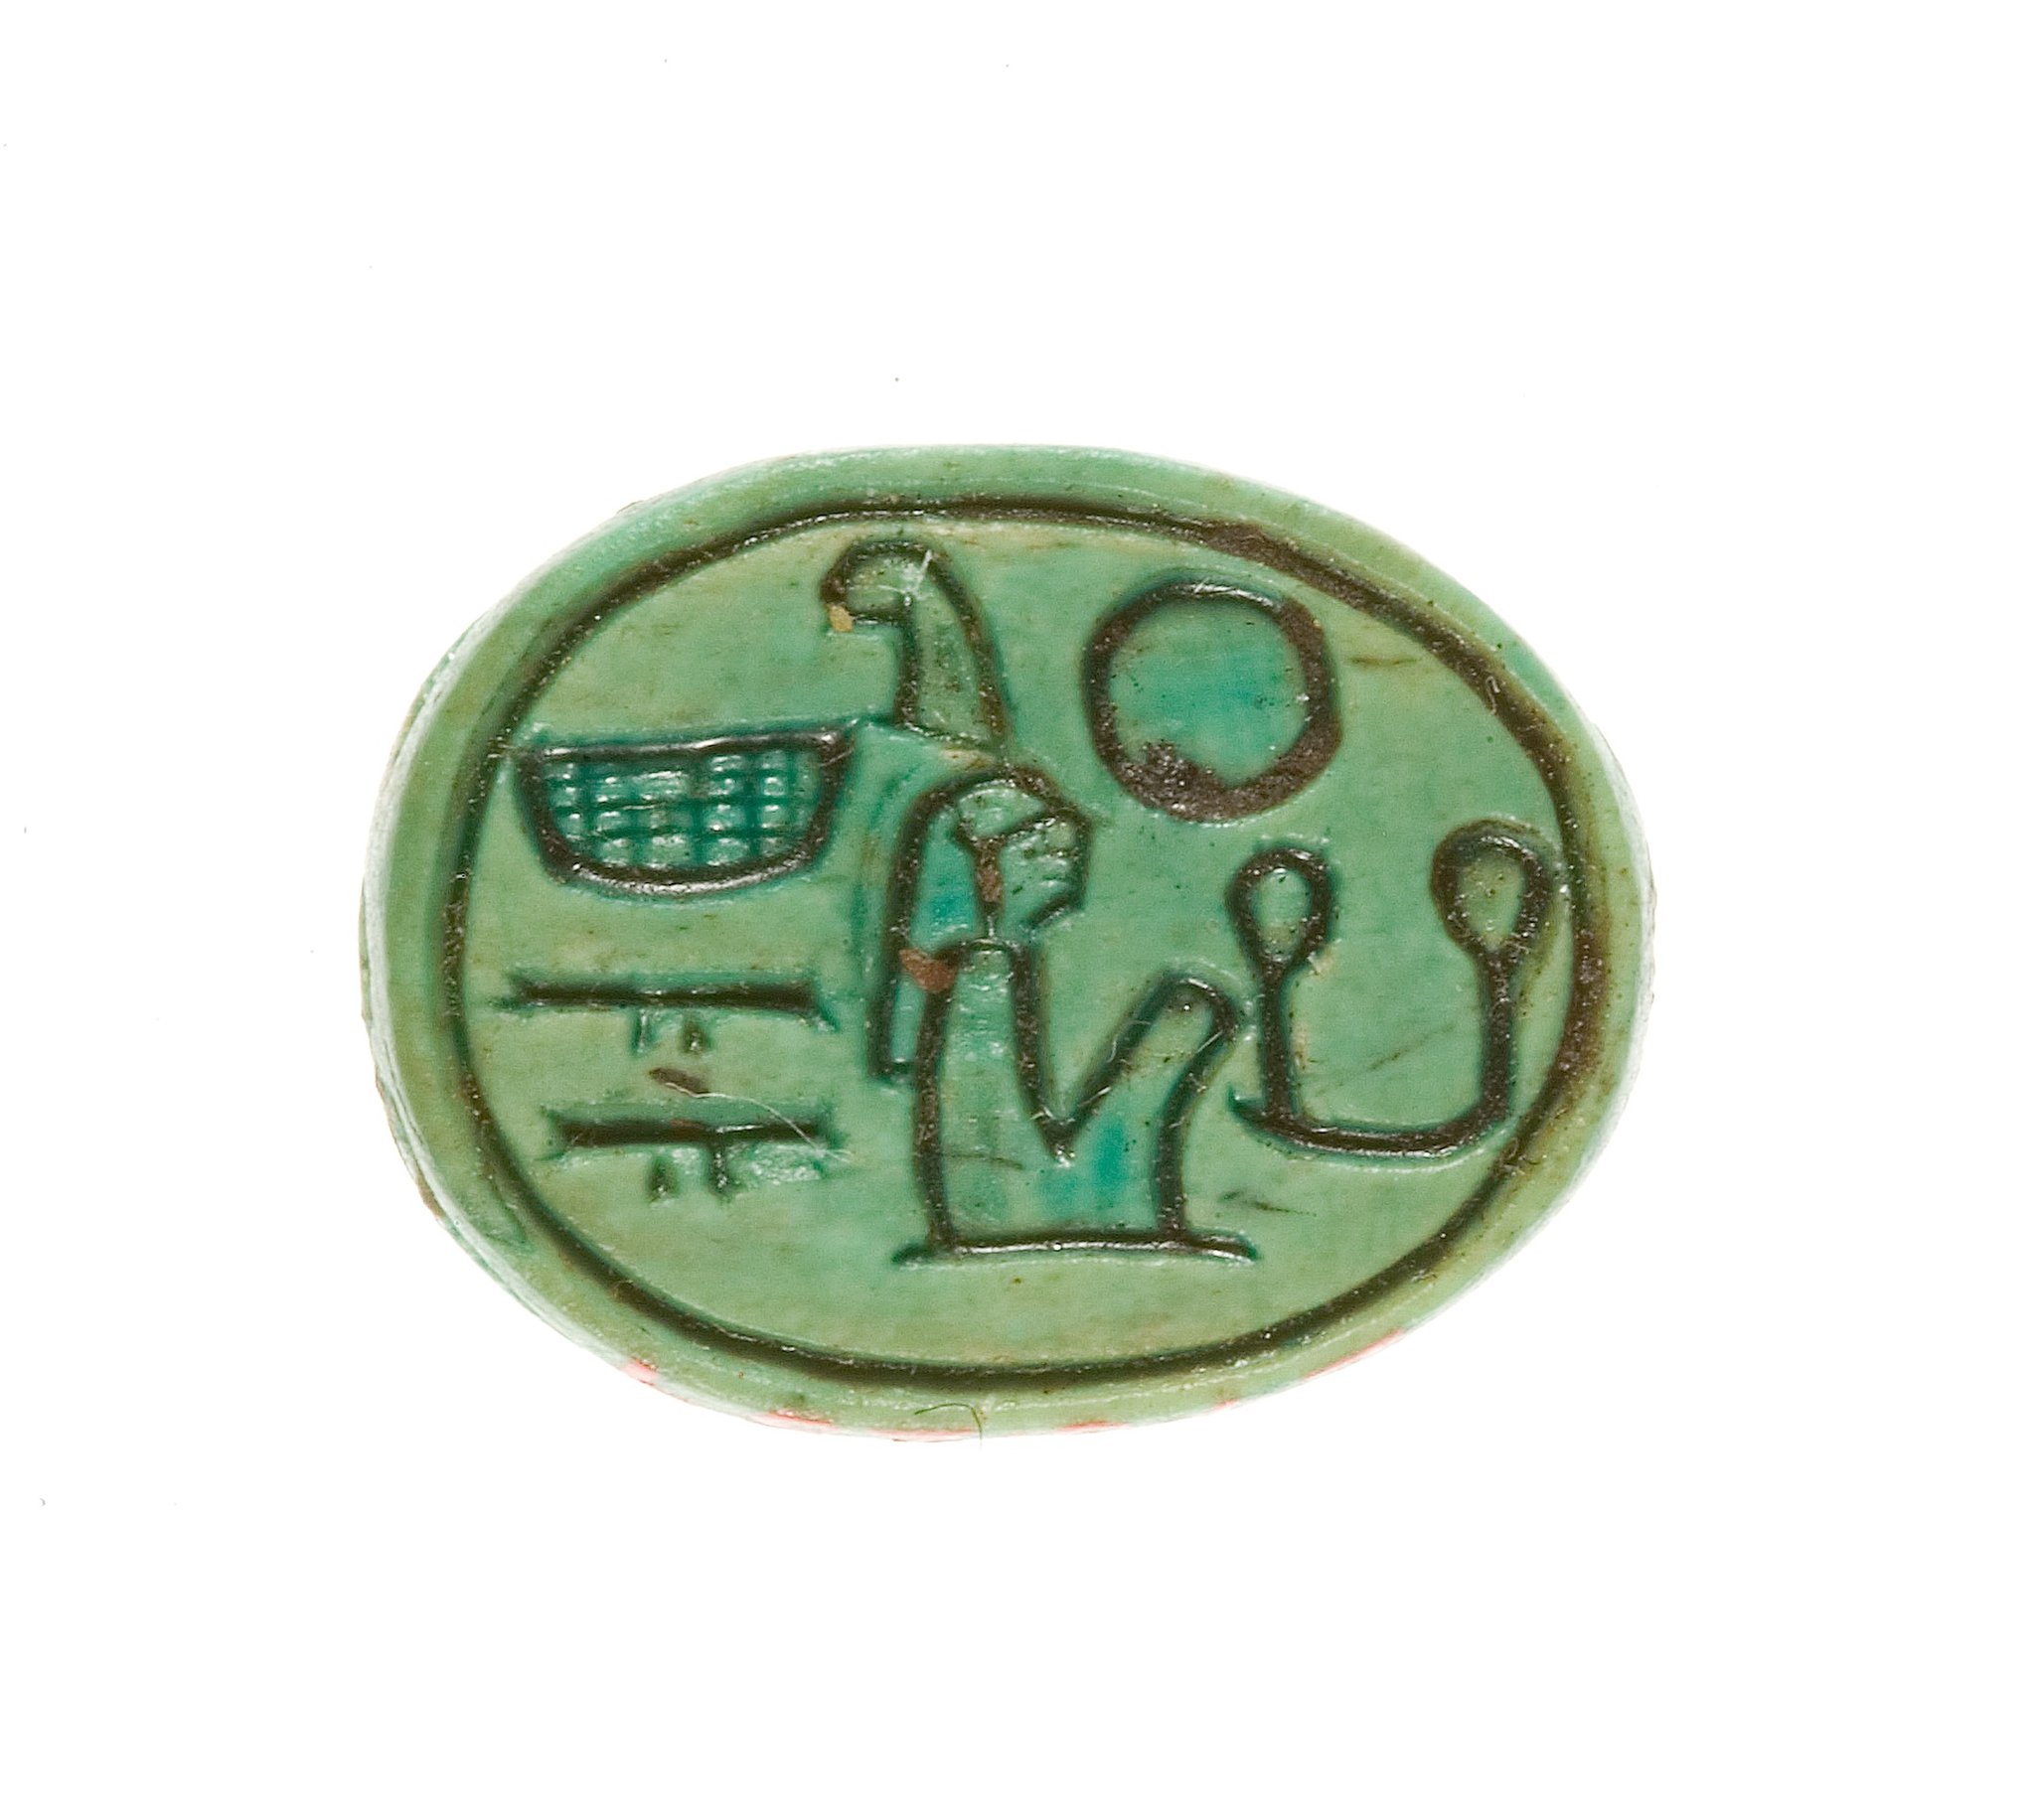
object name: scarab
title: Scarabs from Hatshepsut Foundation Deposits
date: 1479-1458 BCE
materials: stone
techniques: glazing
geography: egypt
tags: scarabs